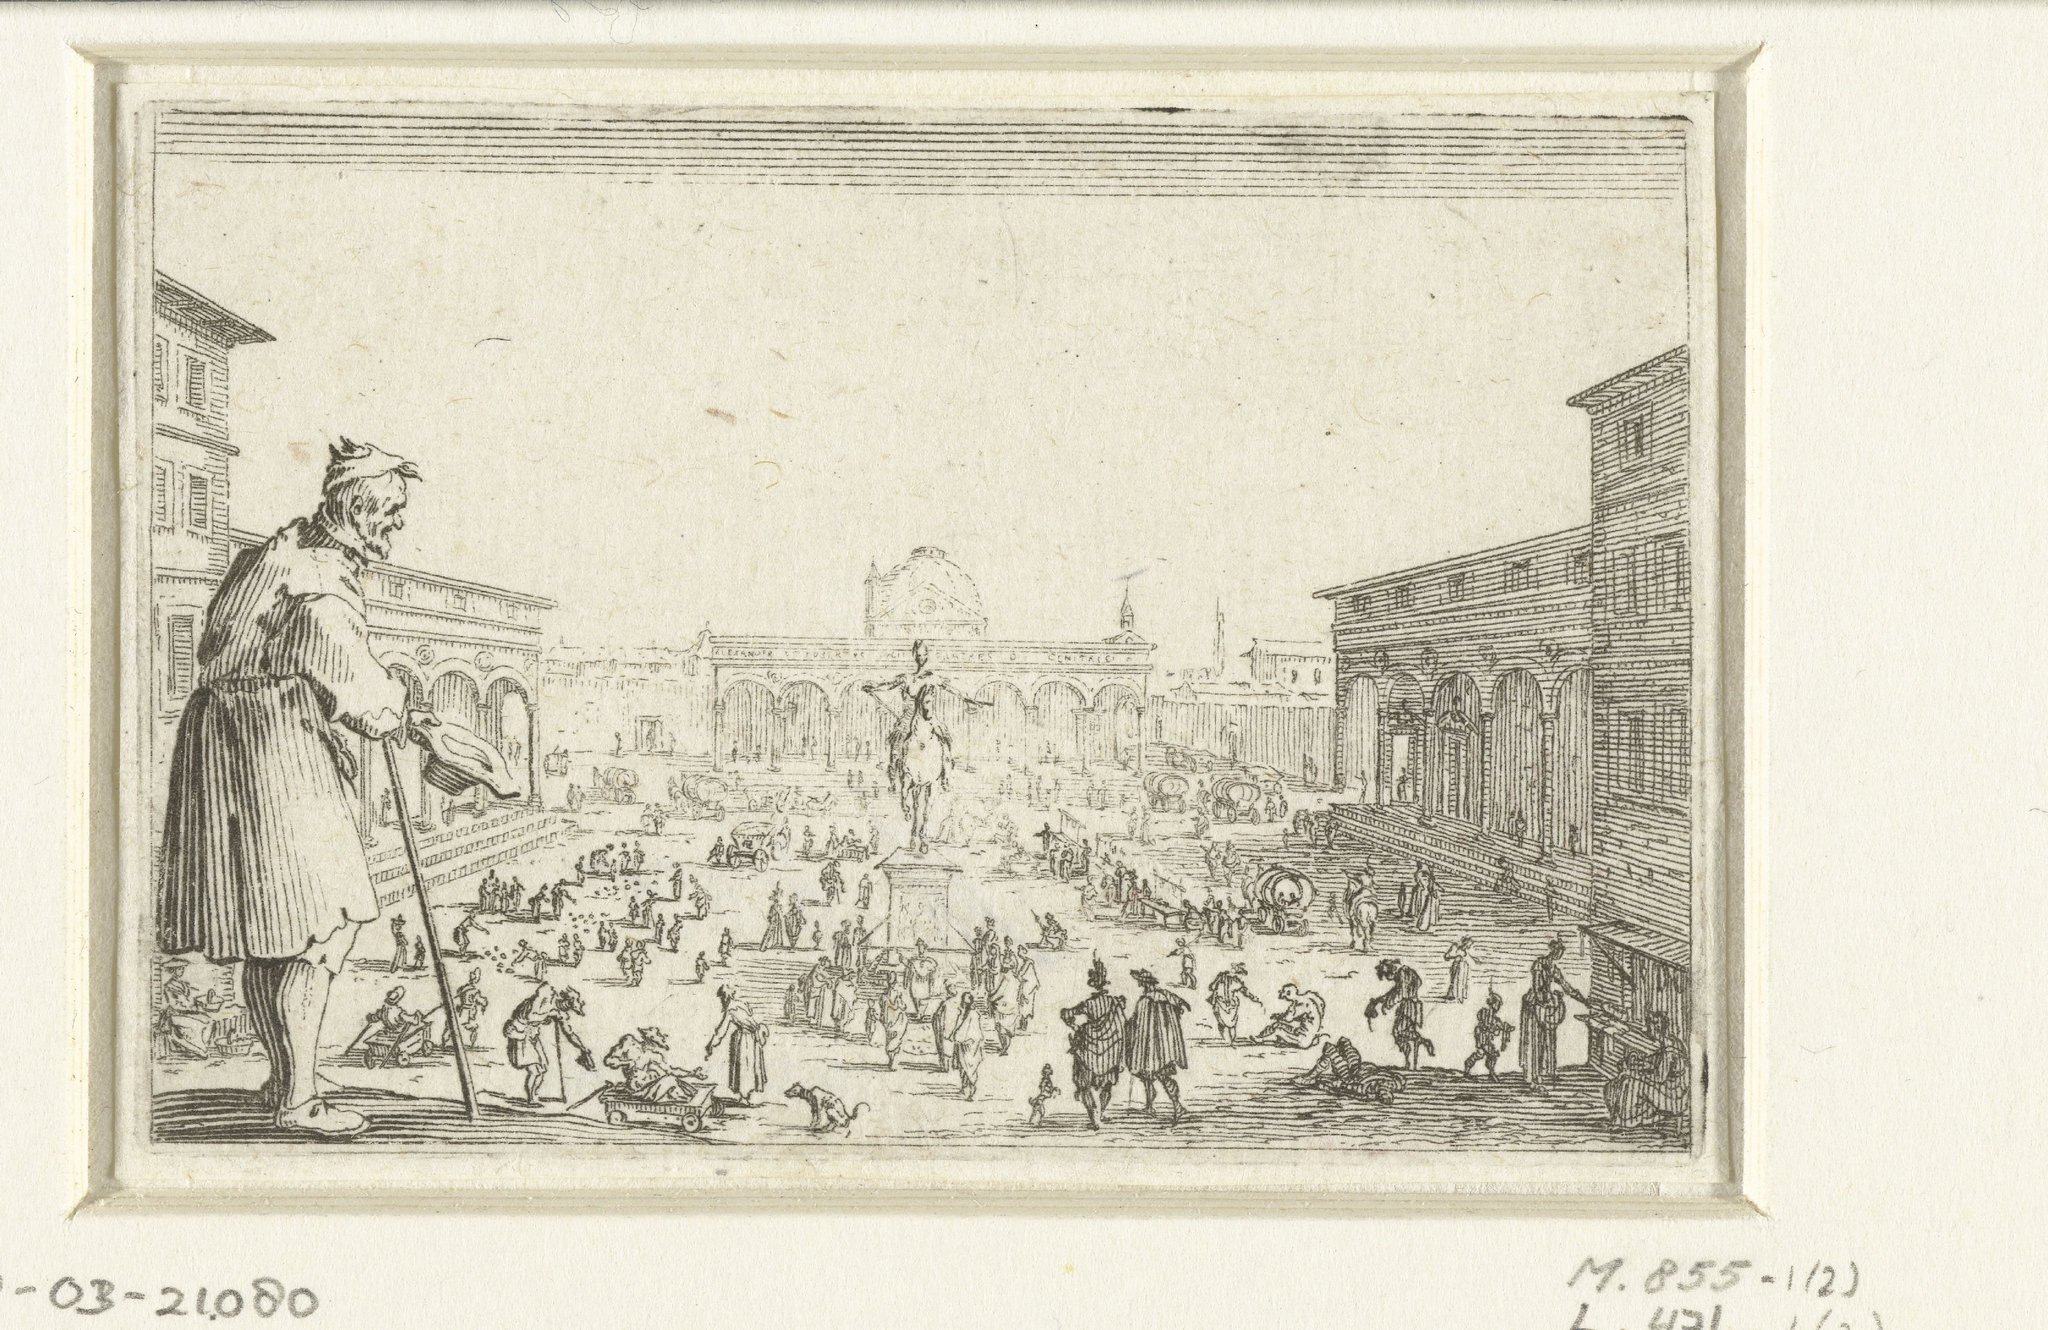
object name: print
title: Diverse figuren en voorstellingen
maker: jacques callot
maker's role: draughtsman, print maker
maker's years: 1592-1635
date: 1621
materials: paper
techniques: etching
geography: nancy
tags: beggar, village square, place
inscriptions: collector's mark: Lugt 240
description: Links op de voorgrond staat een man met een wandelstok; hij houdt bedelend zijn hoed in de hand. Op de achtergrond vele figuurtjes op de Piazza della Santissima Annunziata te Florence. Deze prent is onderdeel van een serie van 48 prenten (50 incl. titelblad en dedicatieblad) met diverse onderwerpen (o.a. mannen en vrouwen in verschillende houdingen, landschappen, gebouwen en festiviteiten in Florence). Mogelijk zijn deze prenten bedoeld geweest als tekenvoorbeelden.